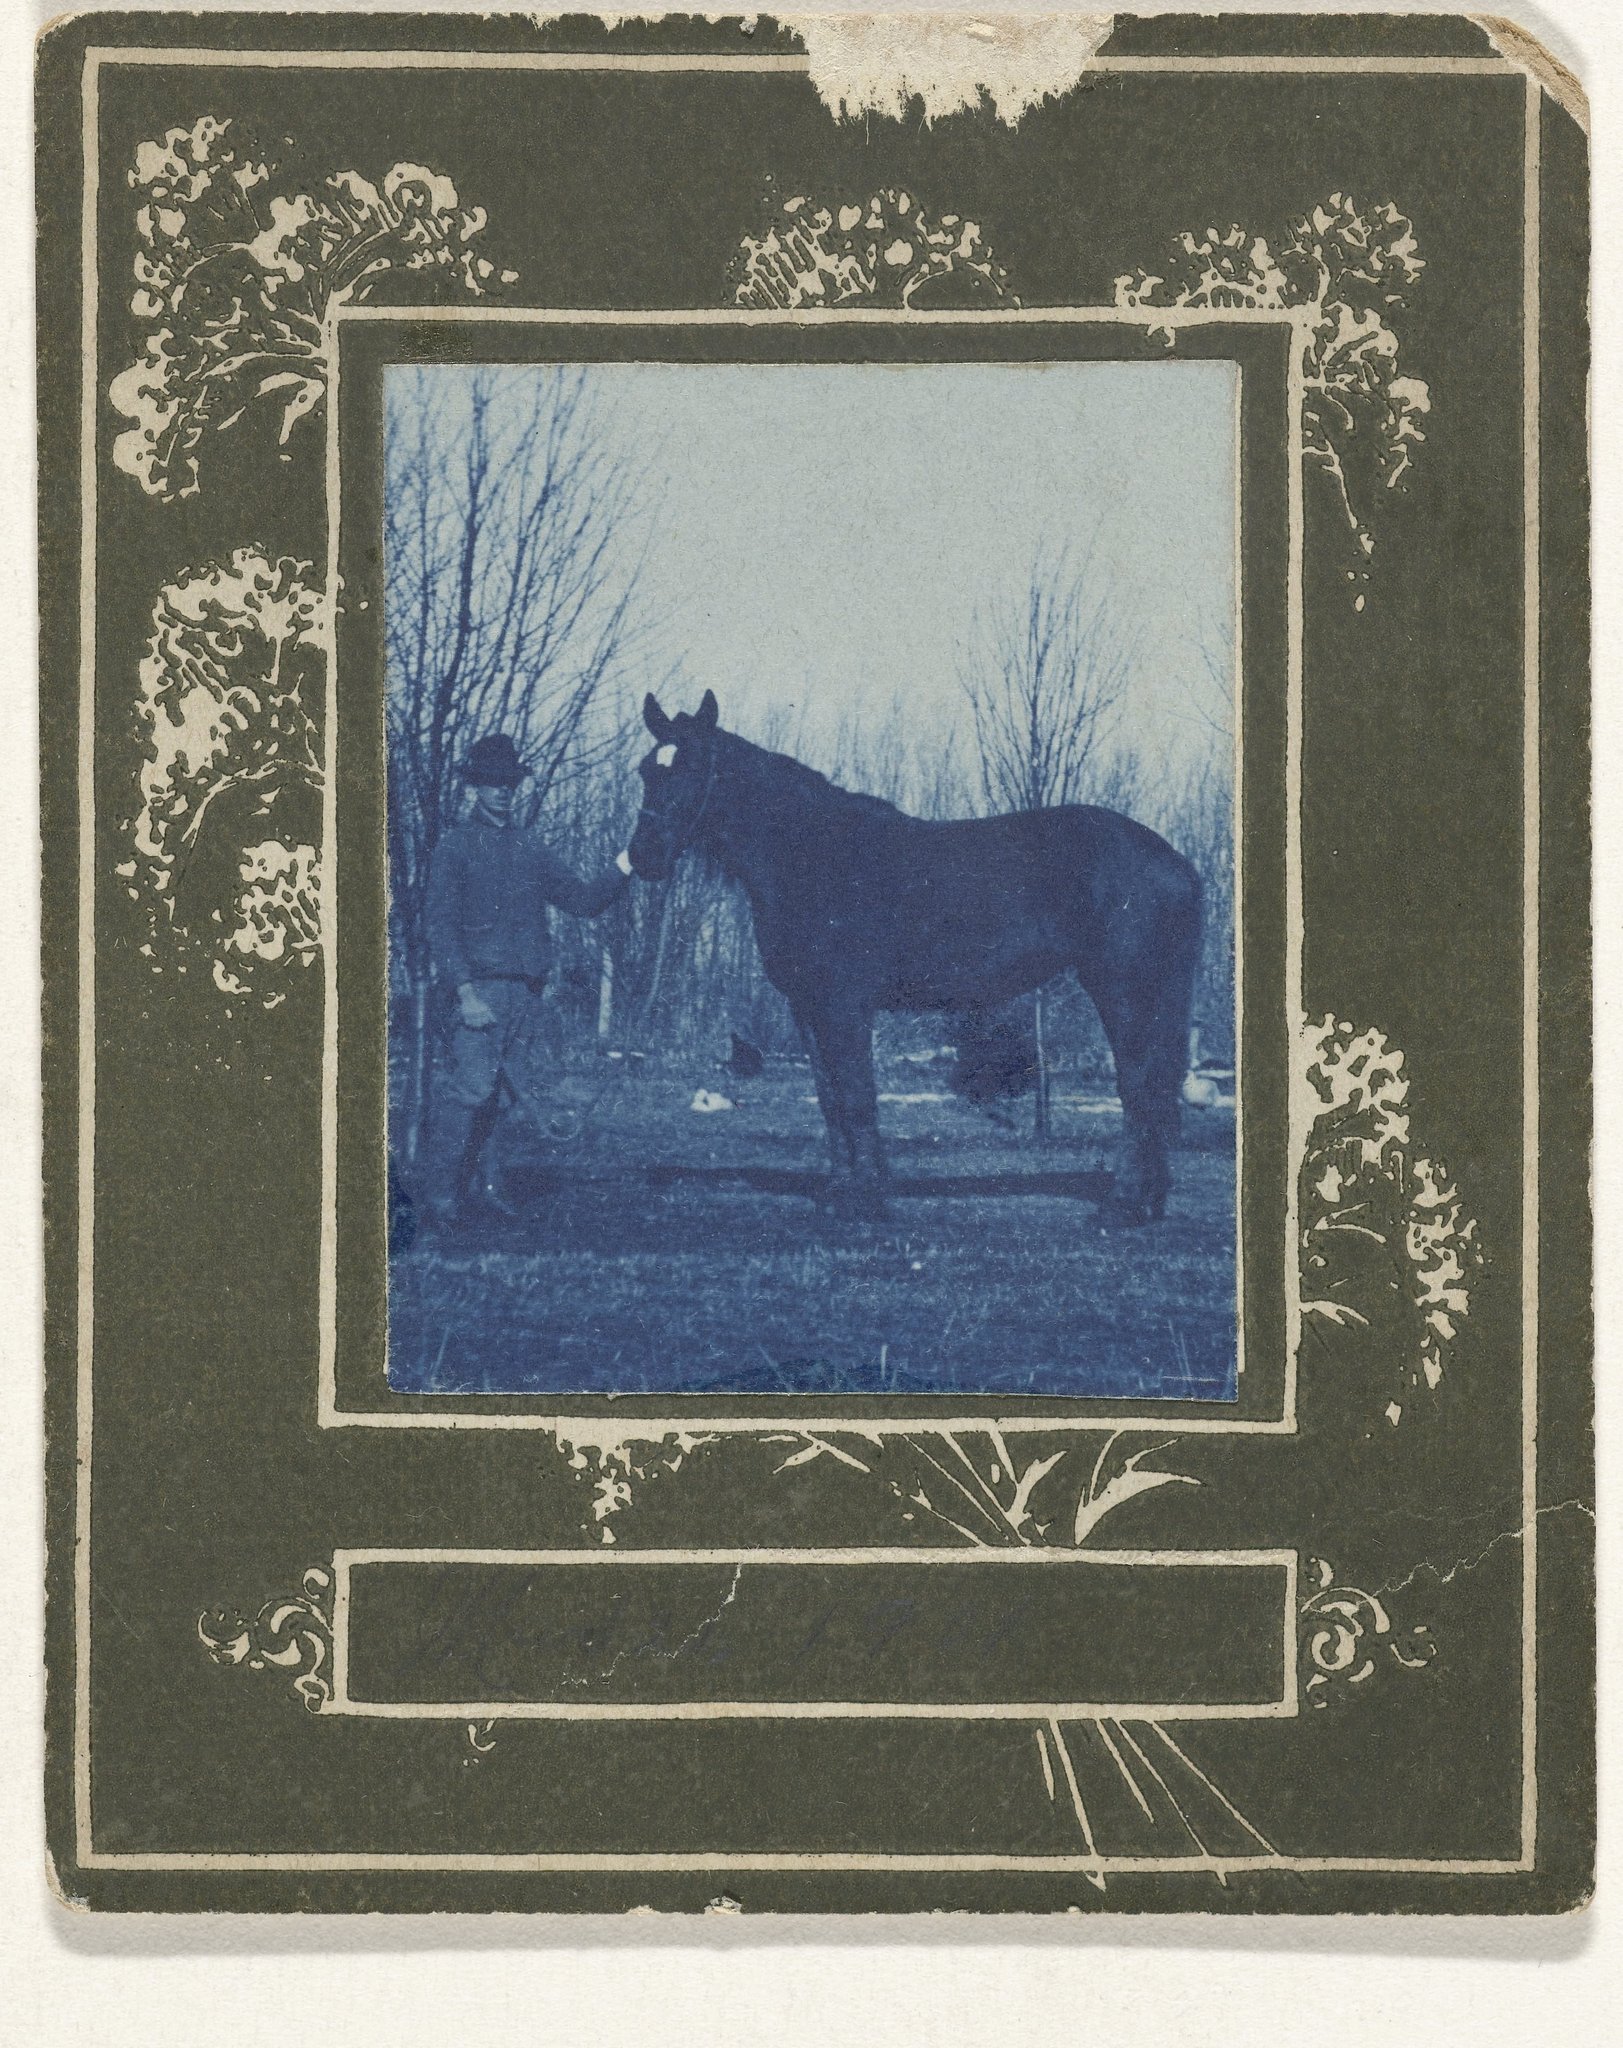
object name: photograph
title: Man staand bij het paard Pet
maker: Anonymous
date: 1899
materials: cardboard, photographic support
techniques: cyanotype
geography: united states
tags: horse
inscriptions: date: ‘Mar 21, 1901’, inscription: ‘"Pet" our horse 1899’